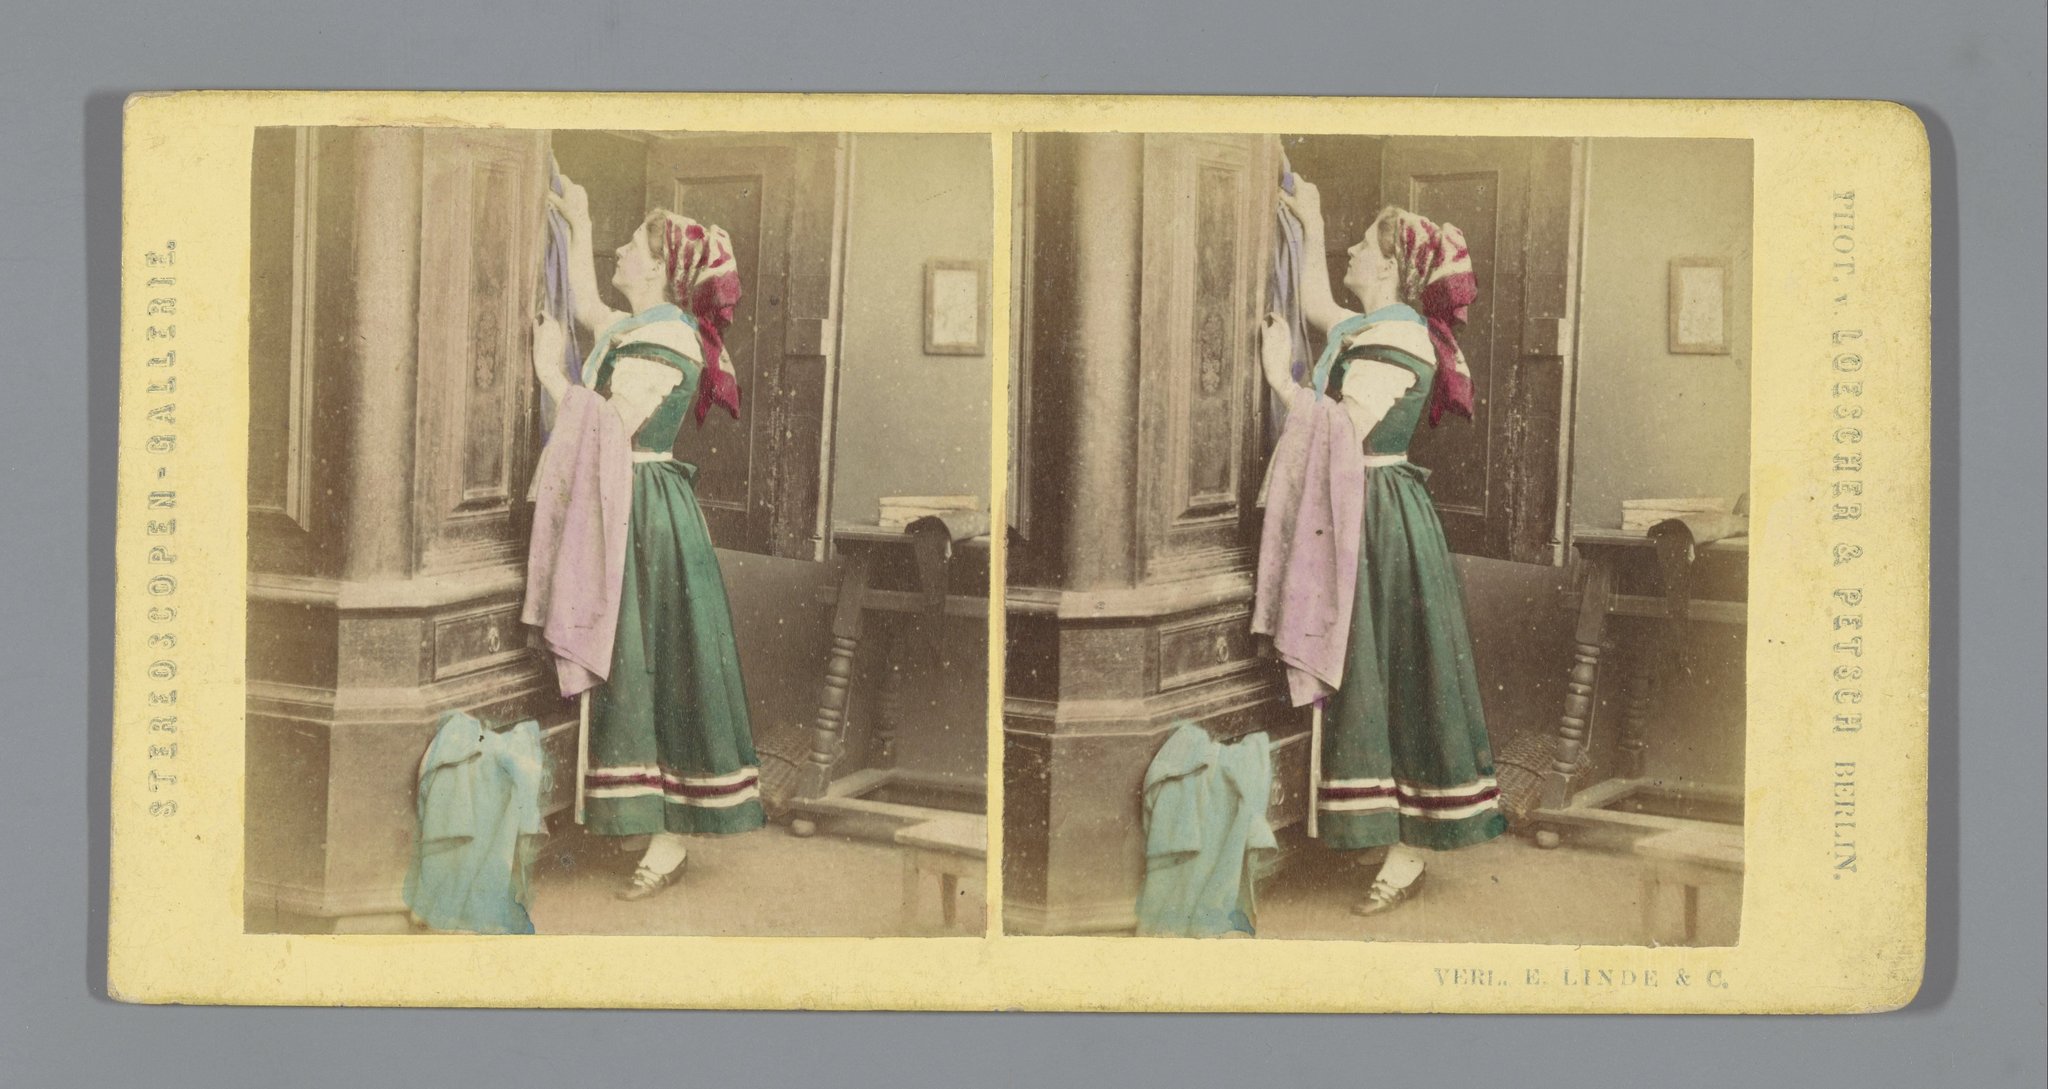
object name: stereograph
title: Schoonmakende vrouw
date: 1863-1868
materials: cardboard, paper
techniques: albumen print, hand coloring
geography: berlin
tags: housekeeper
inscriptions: number: ‘75’